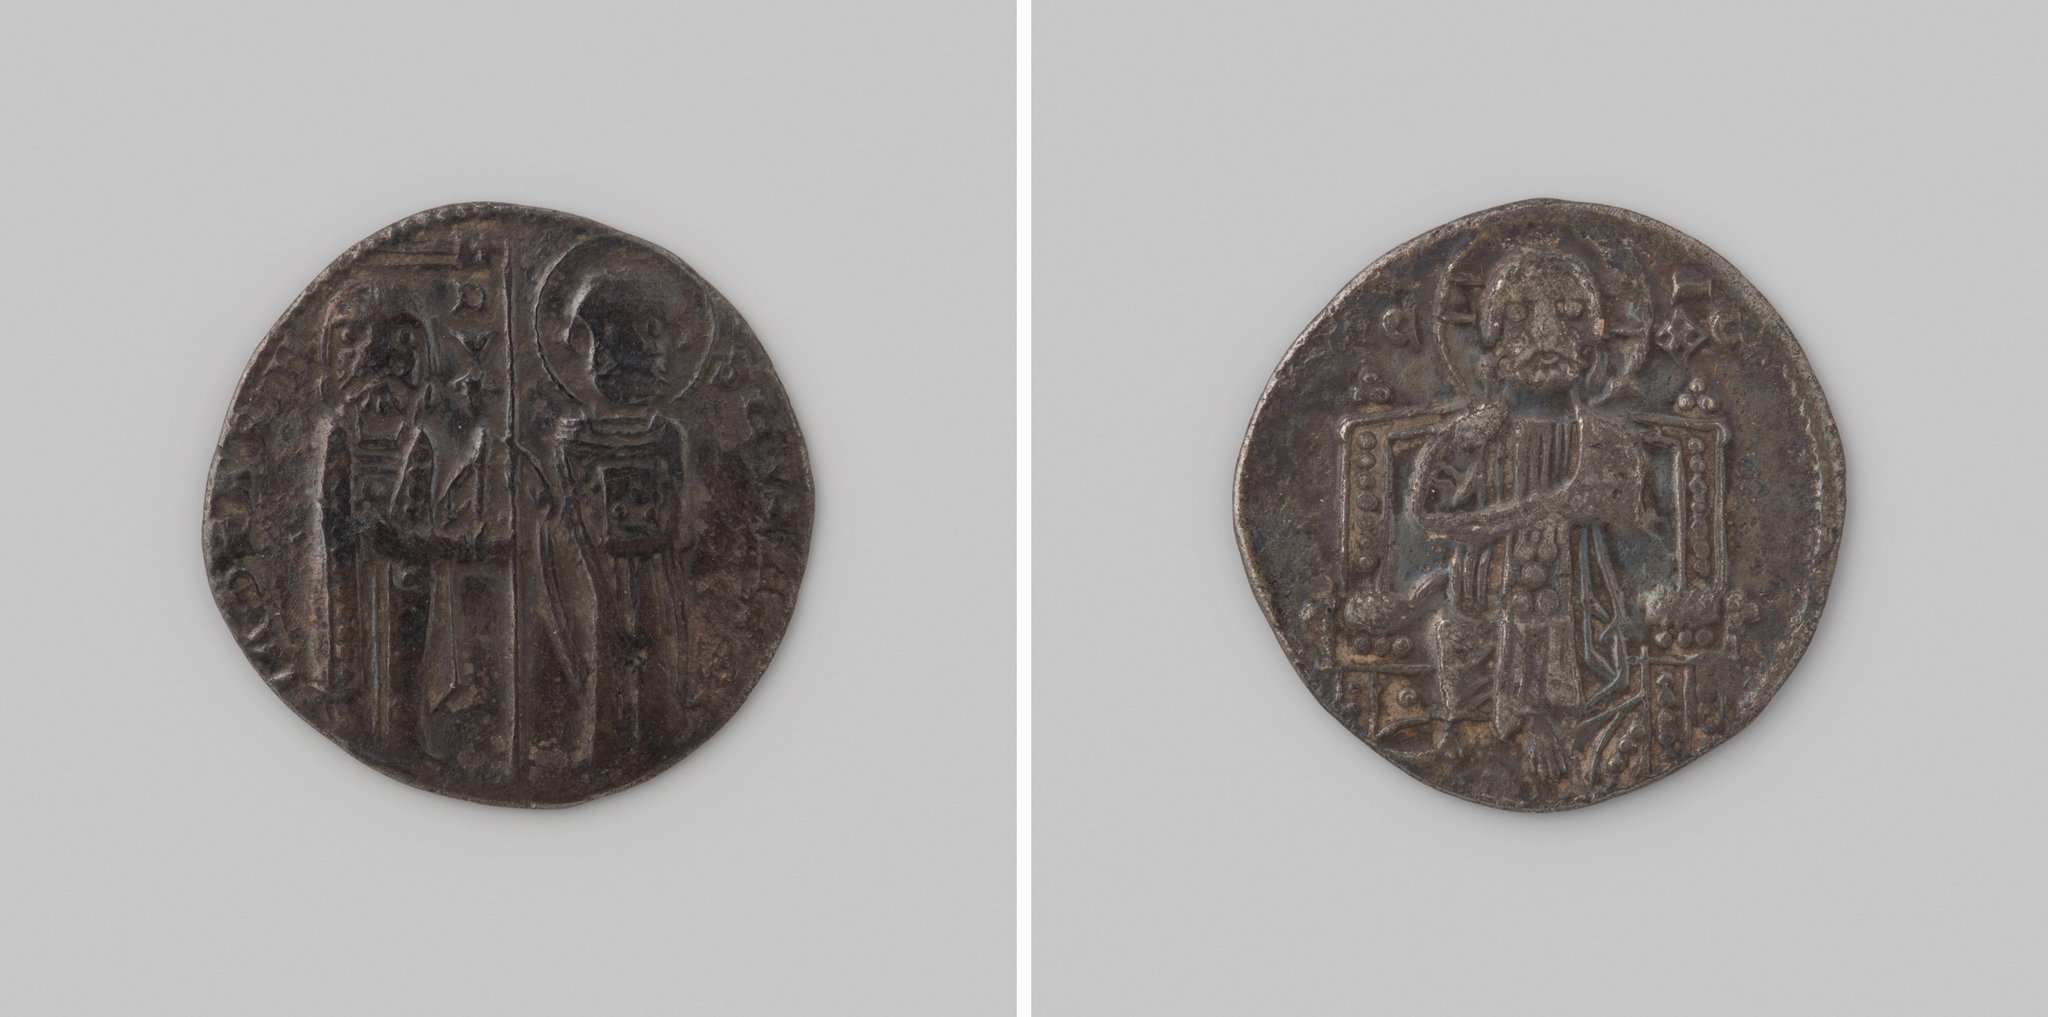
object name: coin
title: Republiek Venetië, grosso, doge Jacopo Contarini, 1275-1280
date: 1275-1280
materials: silver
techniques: striking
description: Zilveren munt. Voorzijde: links de doge en rechts de heilige Marcus met tussen hen een lans, waarop kruis, die zij beiden vasthouden. Keerzijde: Christus in een zetel.